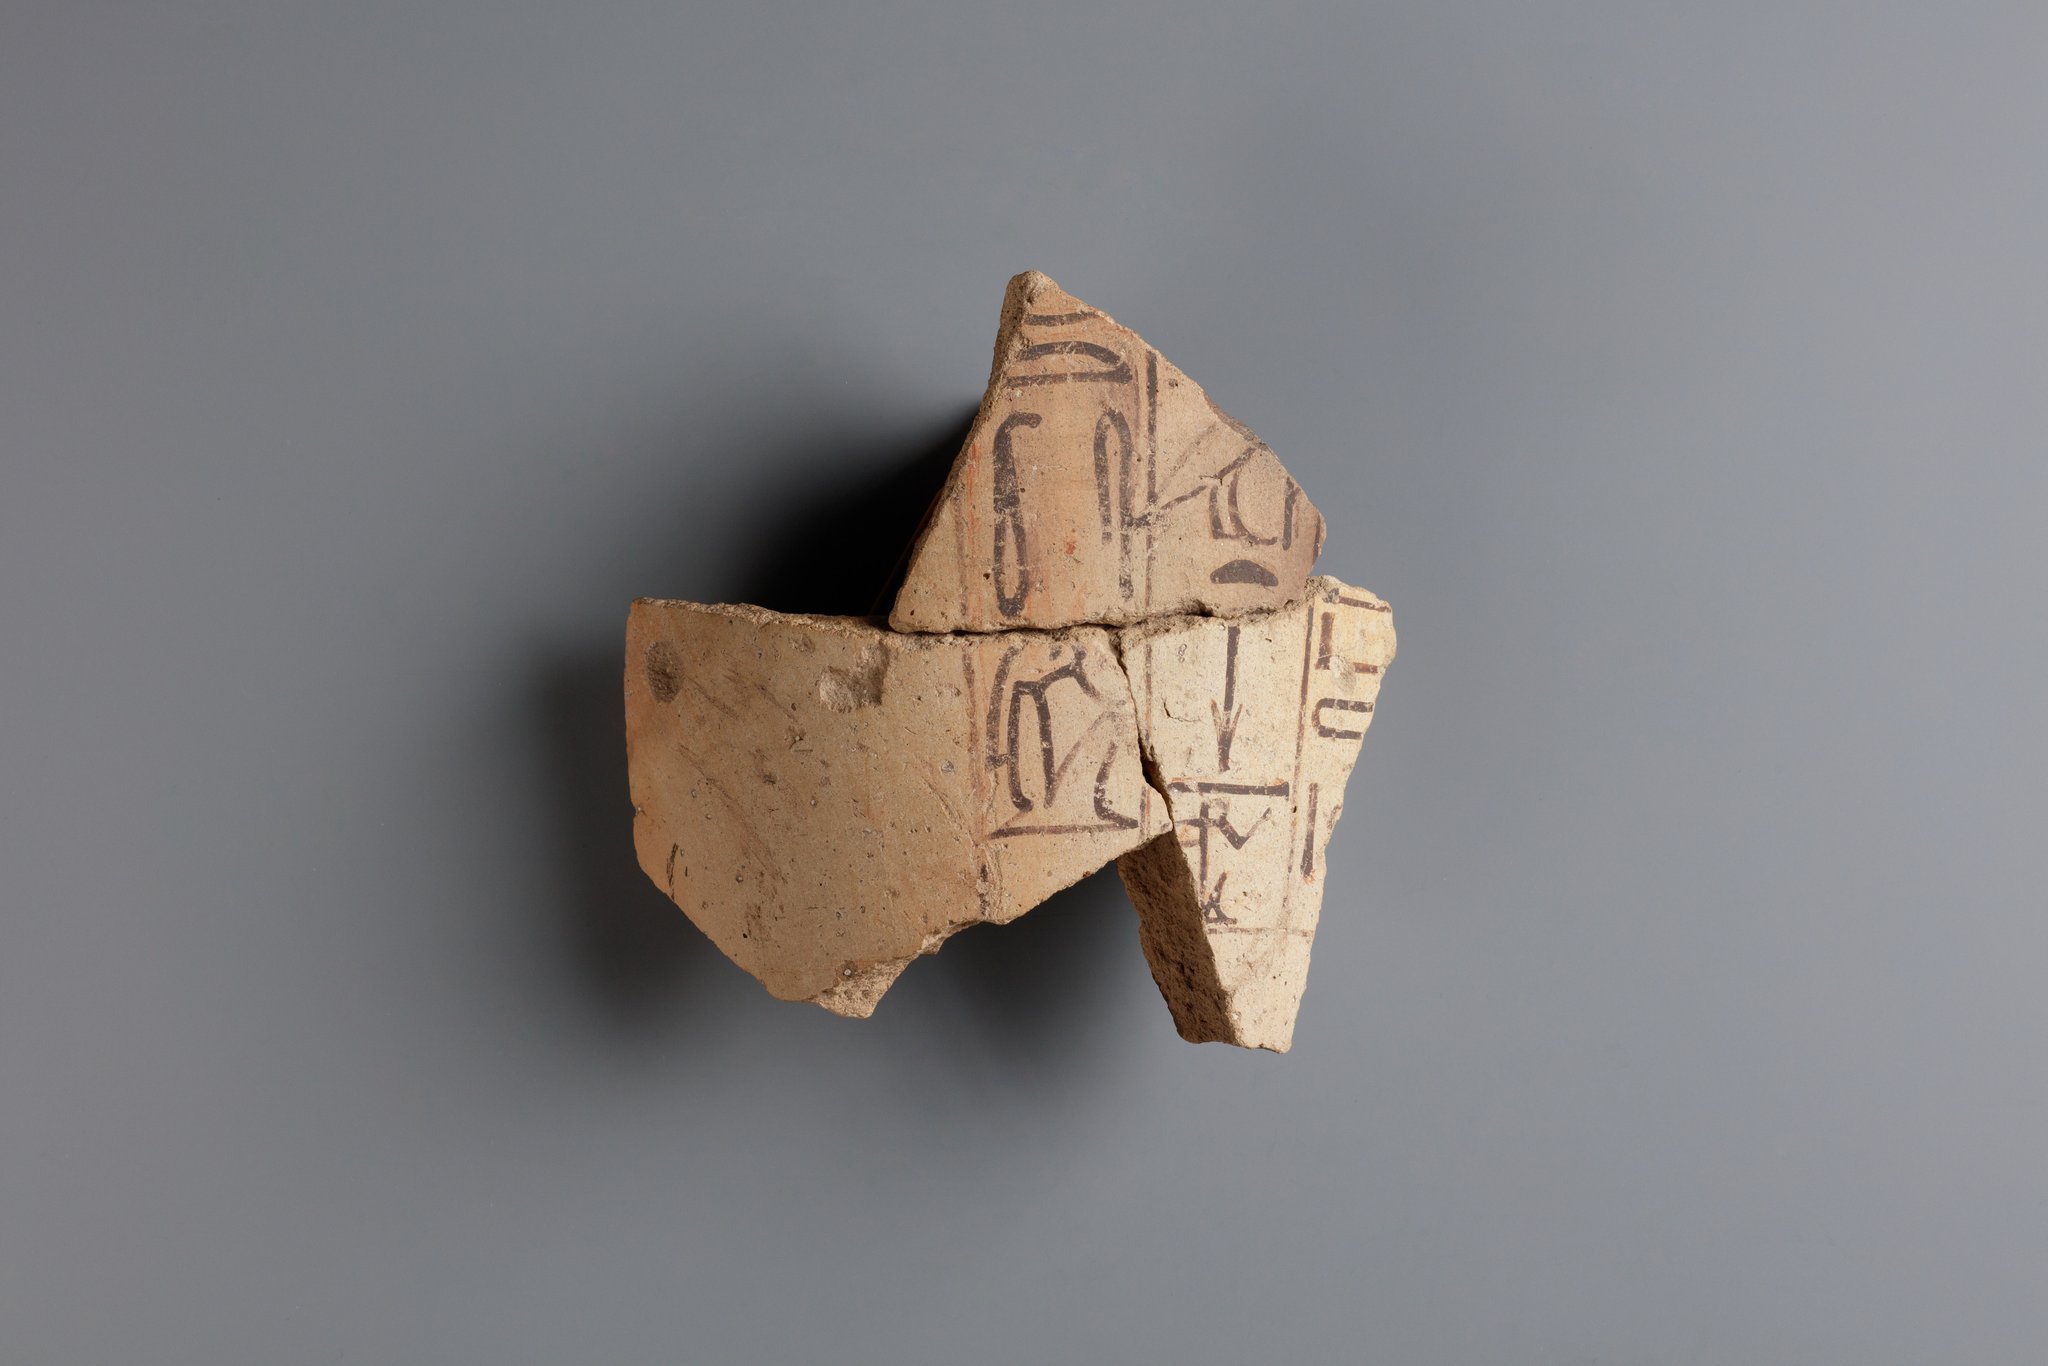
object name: canopic jar, senimen, fragment, imseti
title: Fragments of a Canopic Jar Belonging to Senimen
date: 1479-1458 BCE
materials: paint, pottery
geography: egypt